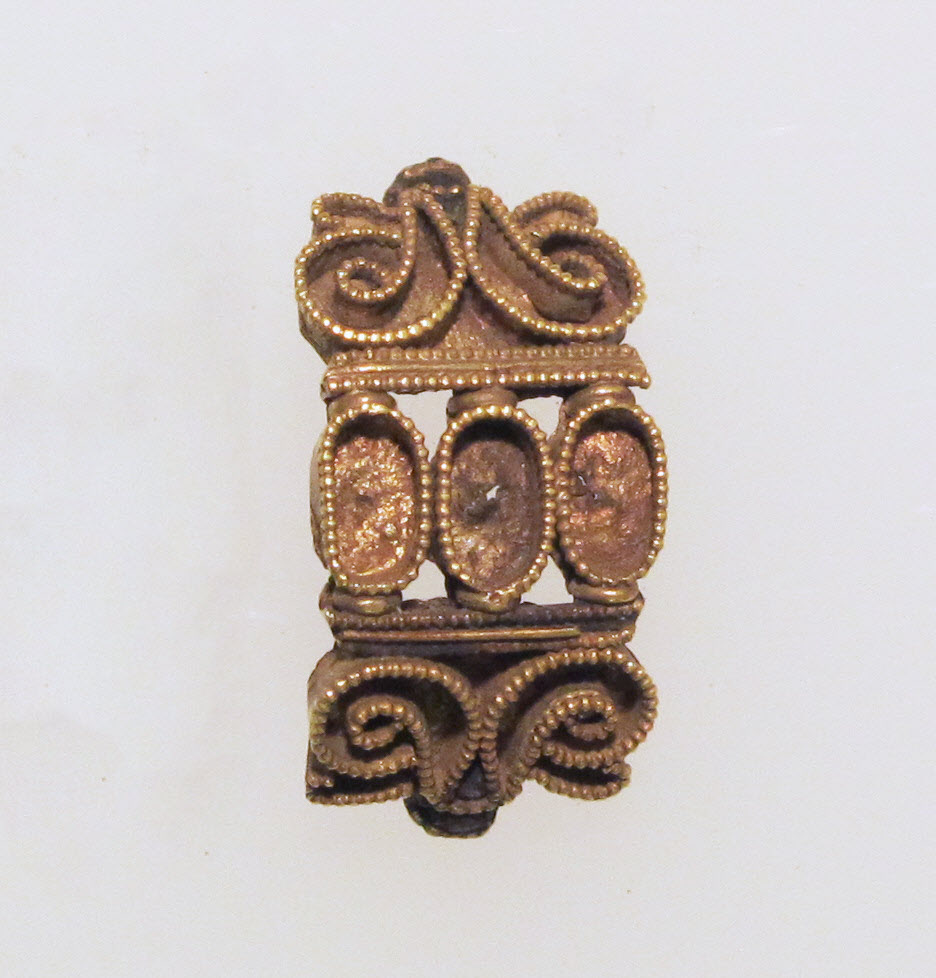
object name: ring, cloisonne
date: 7000 BCE-330 CE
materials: gold